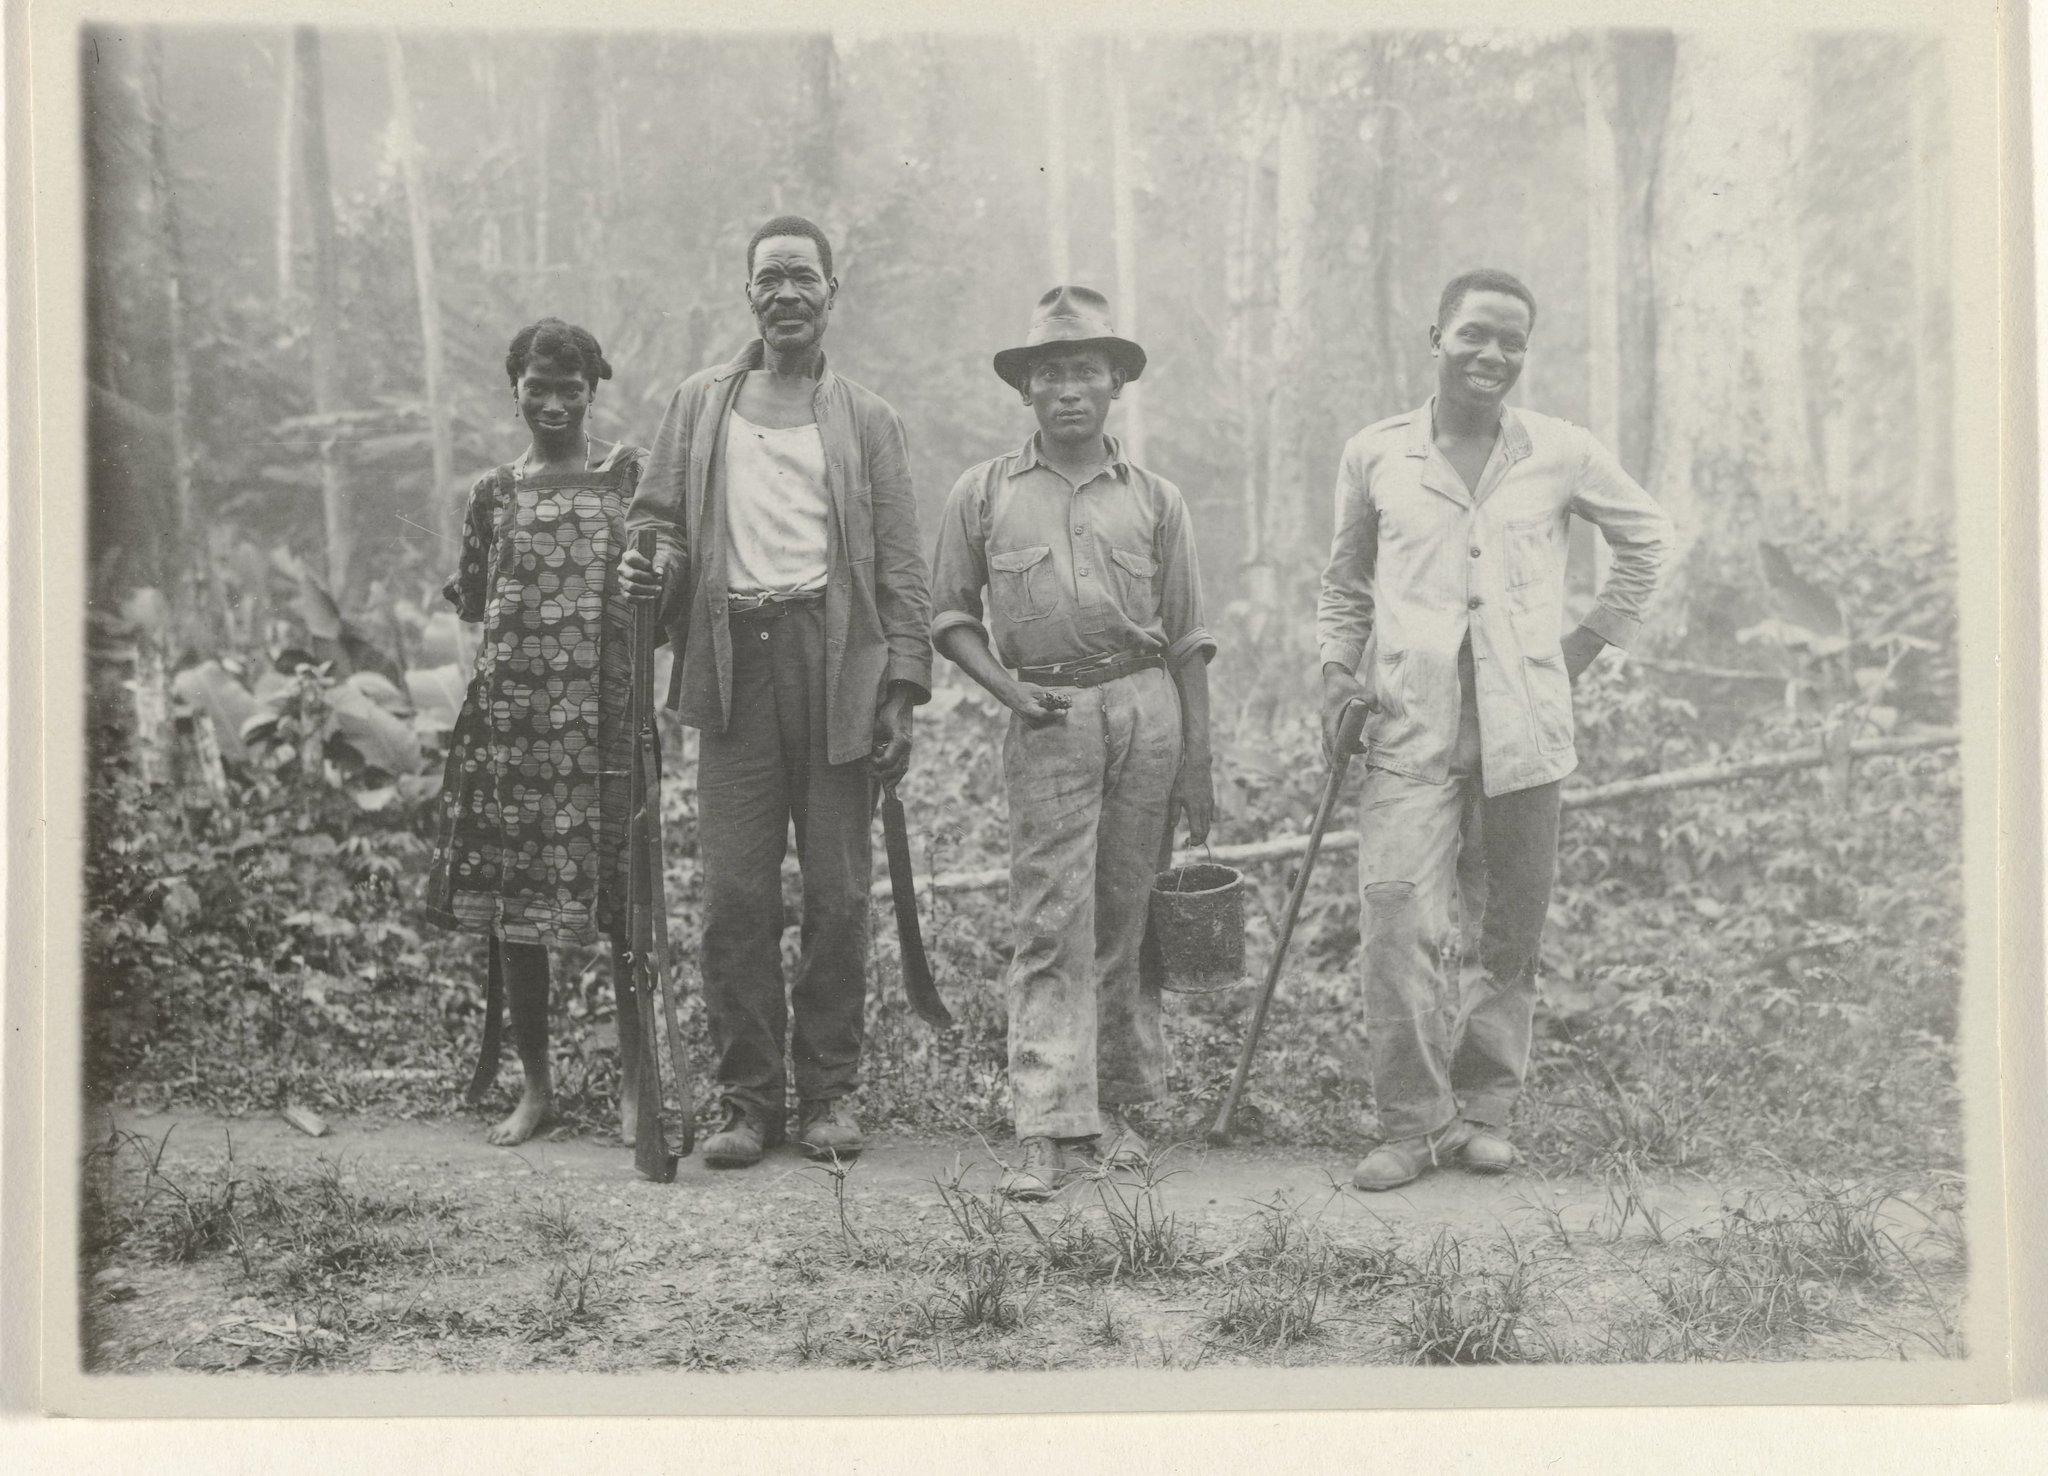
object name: photograph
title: Arbeiders in Moengo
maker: Anonymous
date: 1929-1930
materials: photographic support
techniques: gelatin silver print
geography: suriname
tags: historical persons not known by name